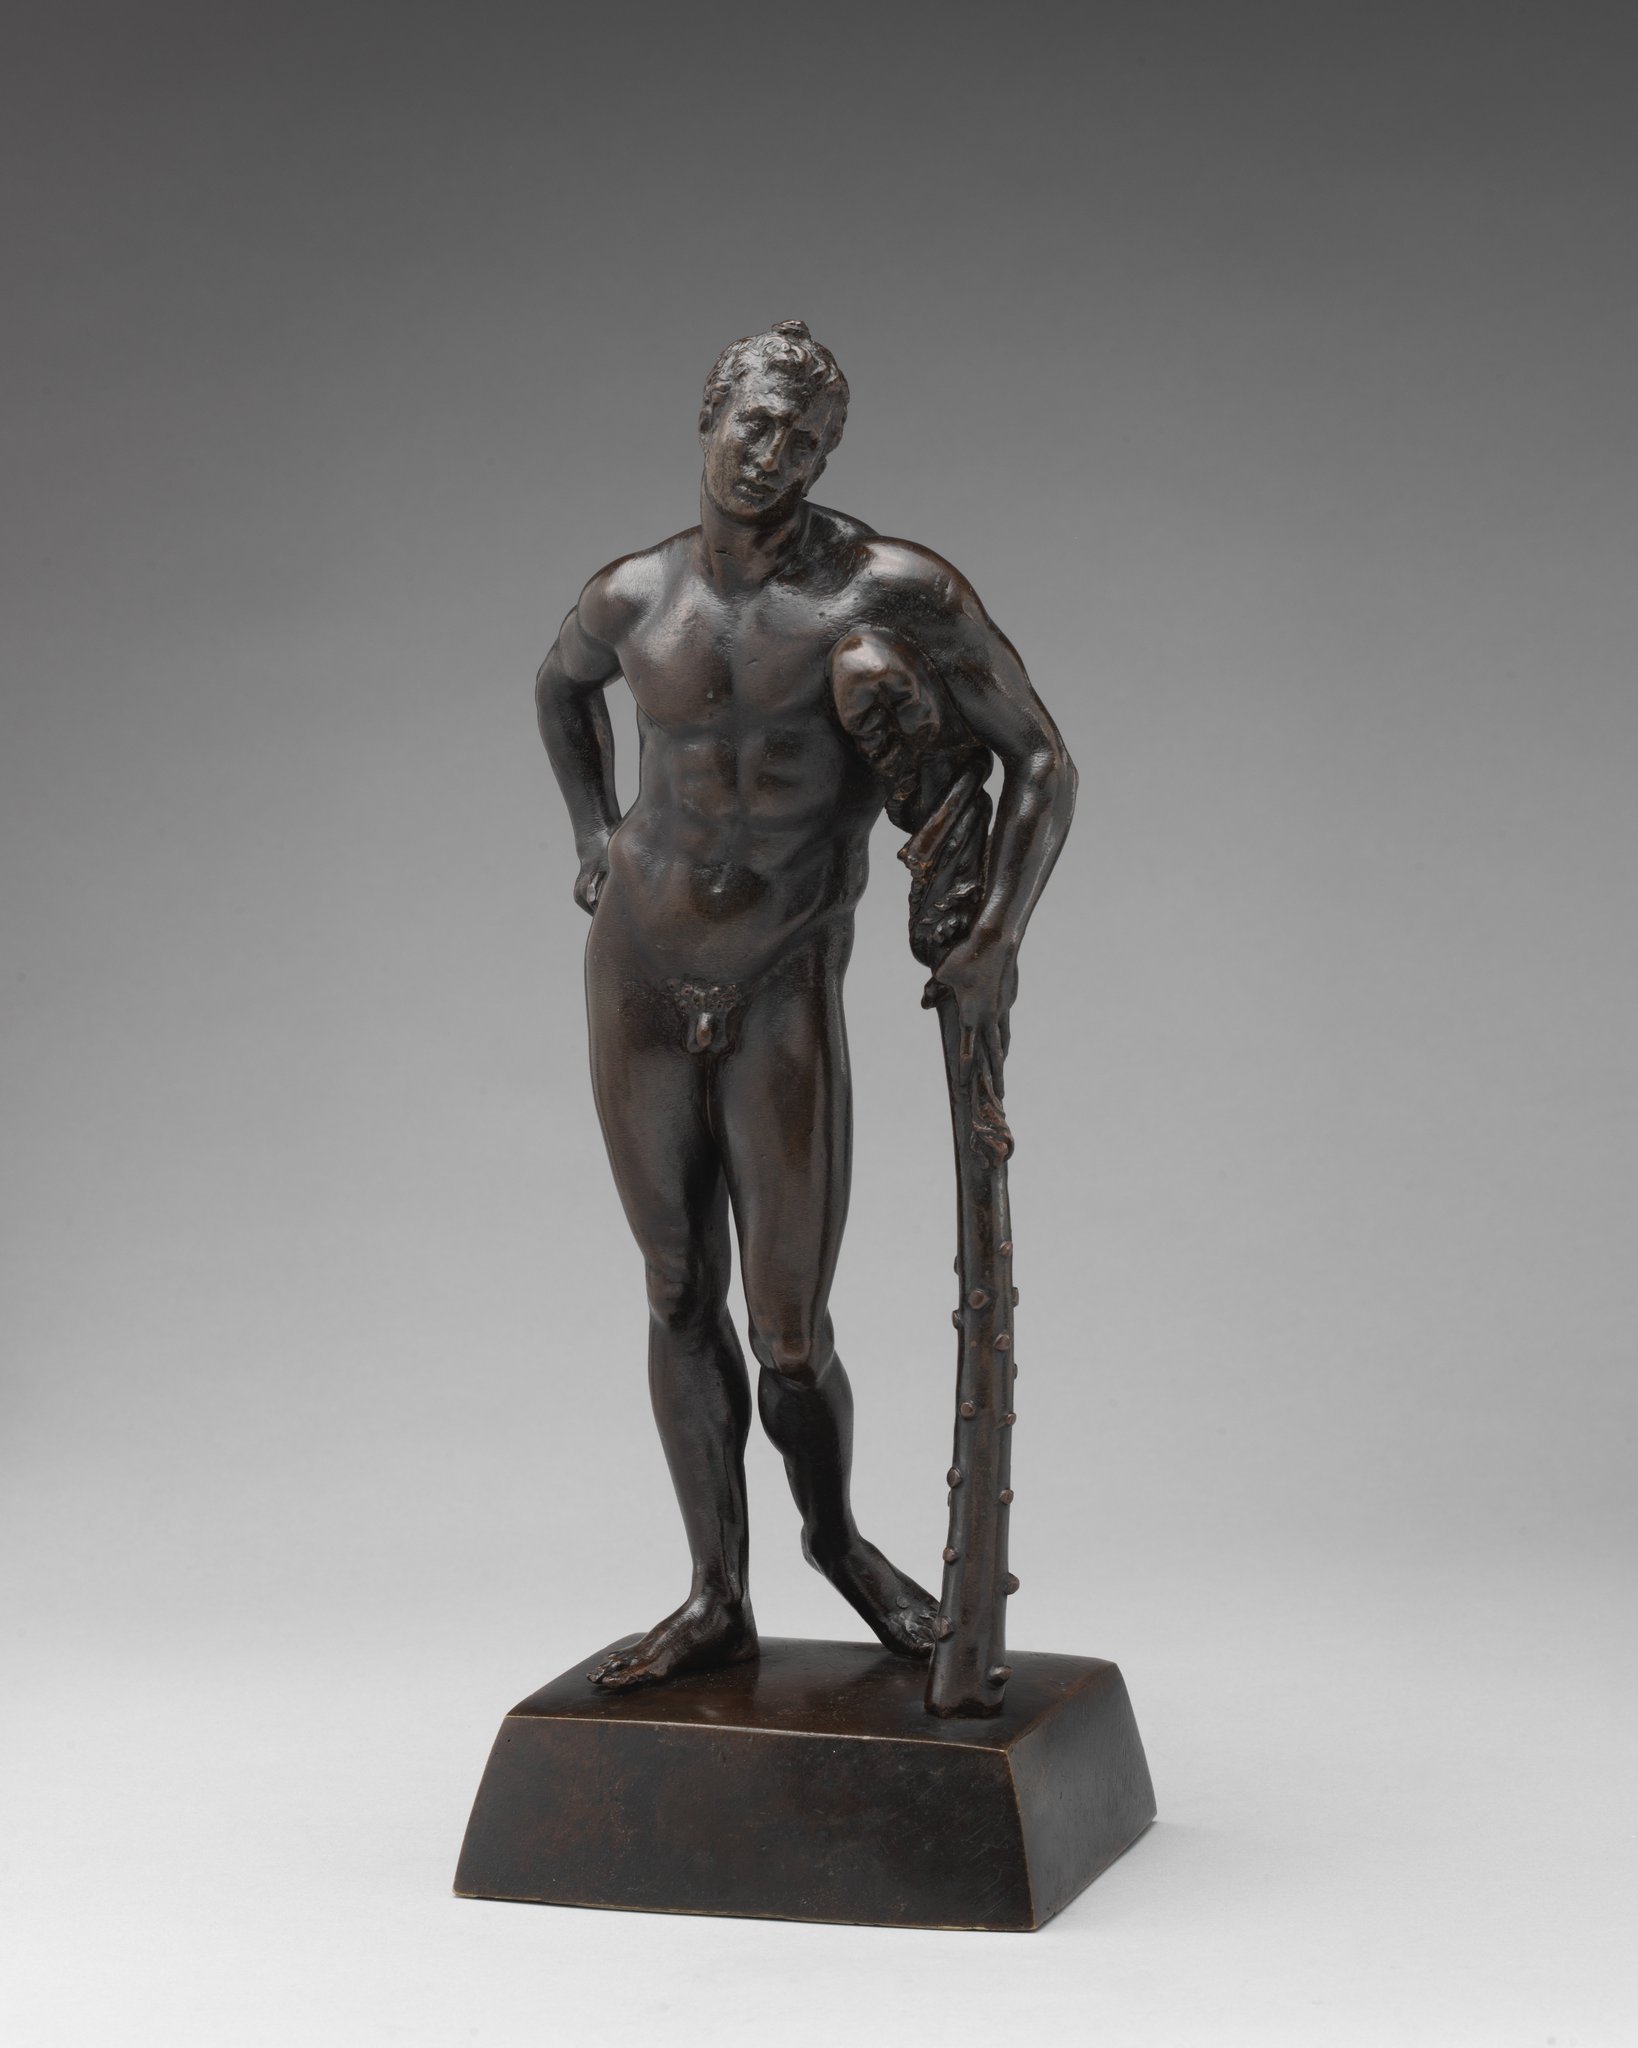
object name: statuette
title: Hercules Leaning on a Club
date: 1601-1700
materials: bronze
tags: male nudes,hercules